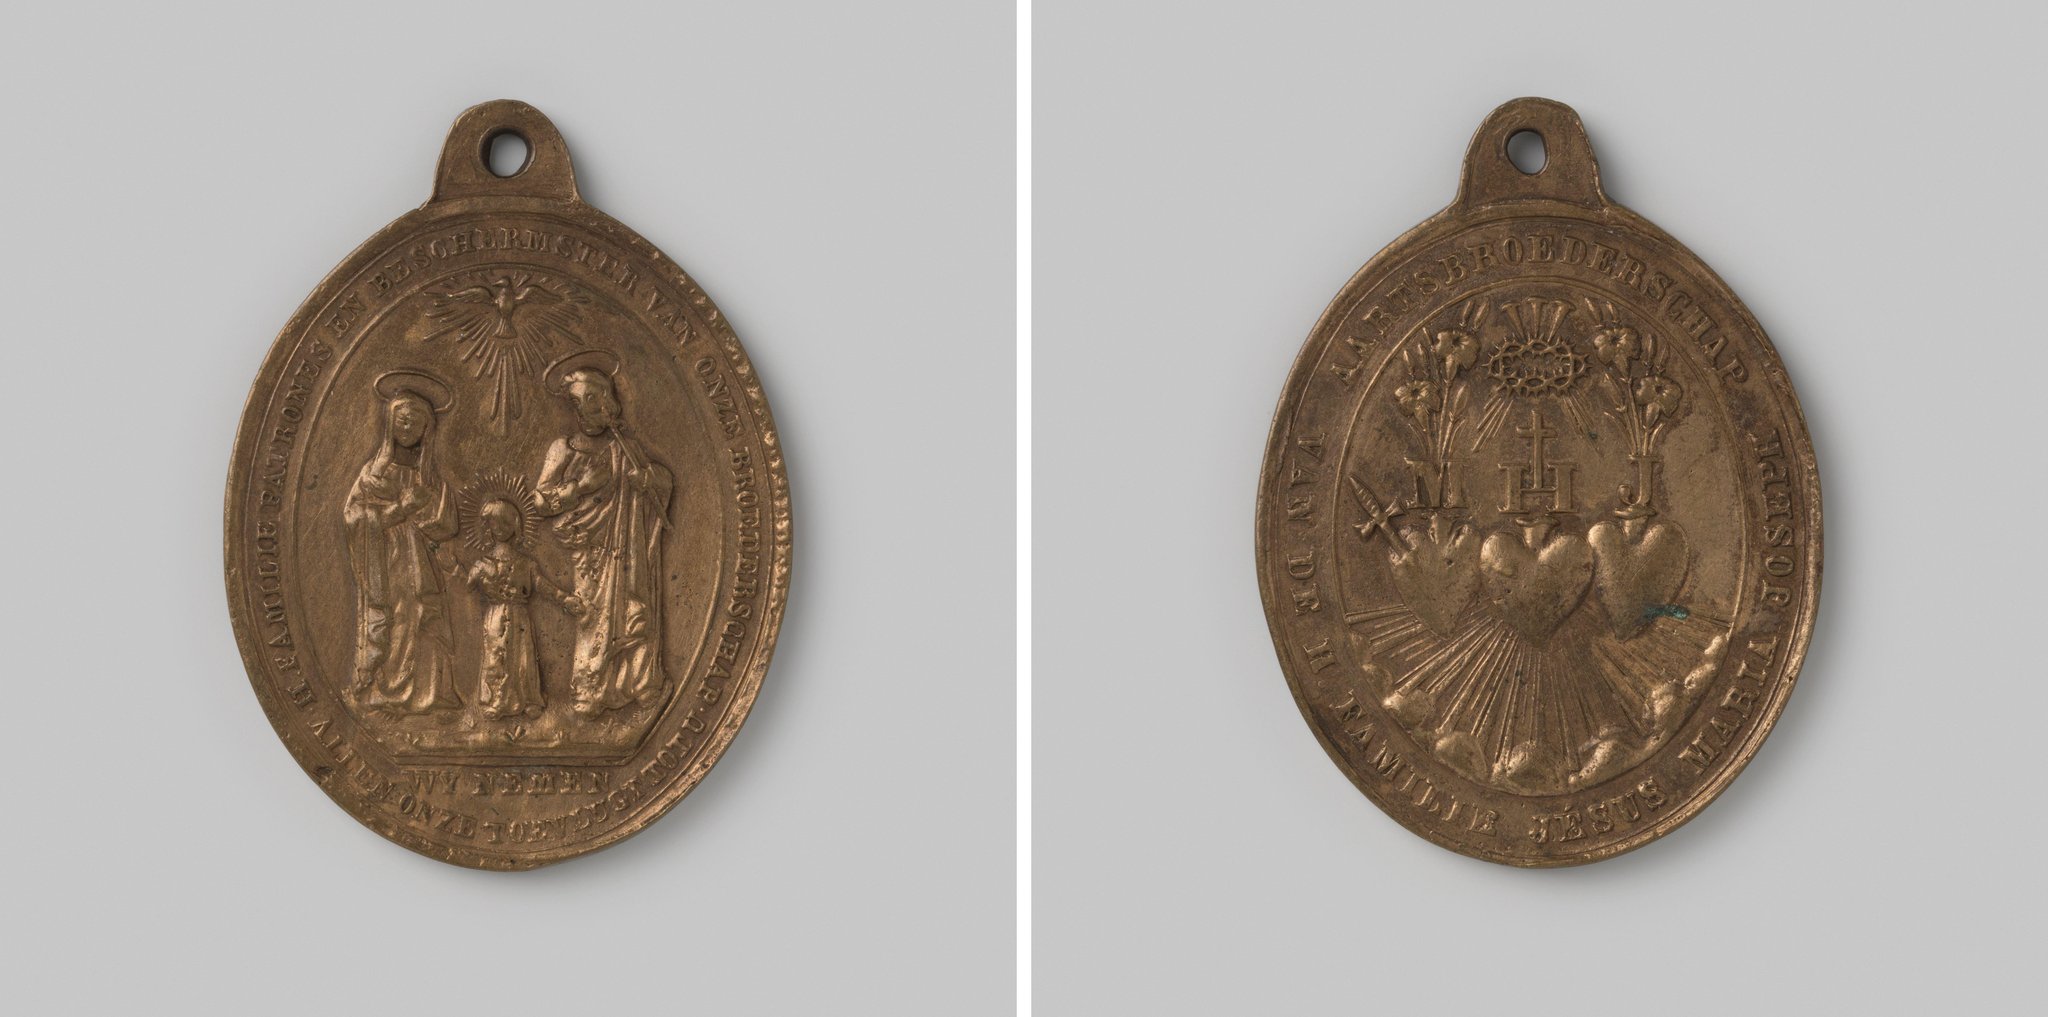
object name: history medal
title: Religieus draagteken van de Aartsbroederschap van de Heilige Familie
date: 1750-1850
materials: brass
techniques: casting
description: Ovalen messing penning met draagoog, op de voorzijde de Heilige Familie onder de Duif als Heilige Geest, mjet afsnedetekst en omschrift, op de keerzijde drie harten met attributen, met omschrift.